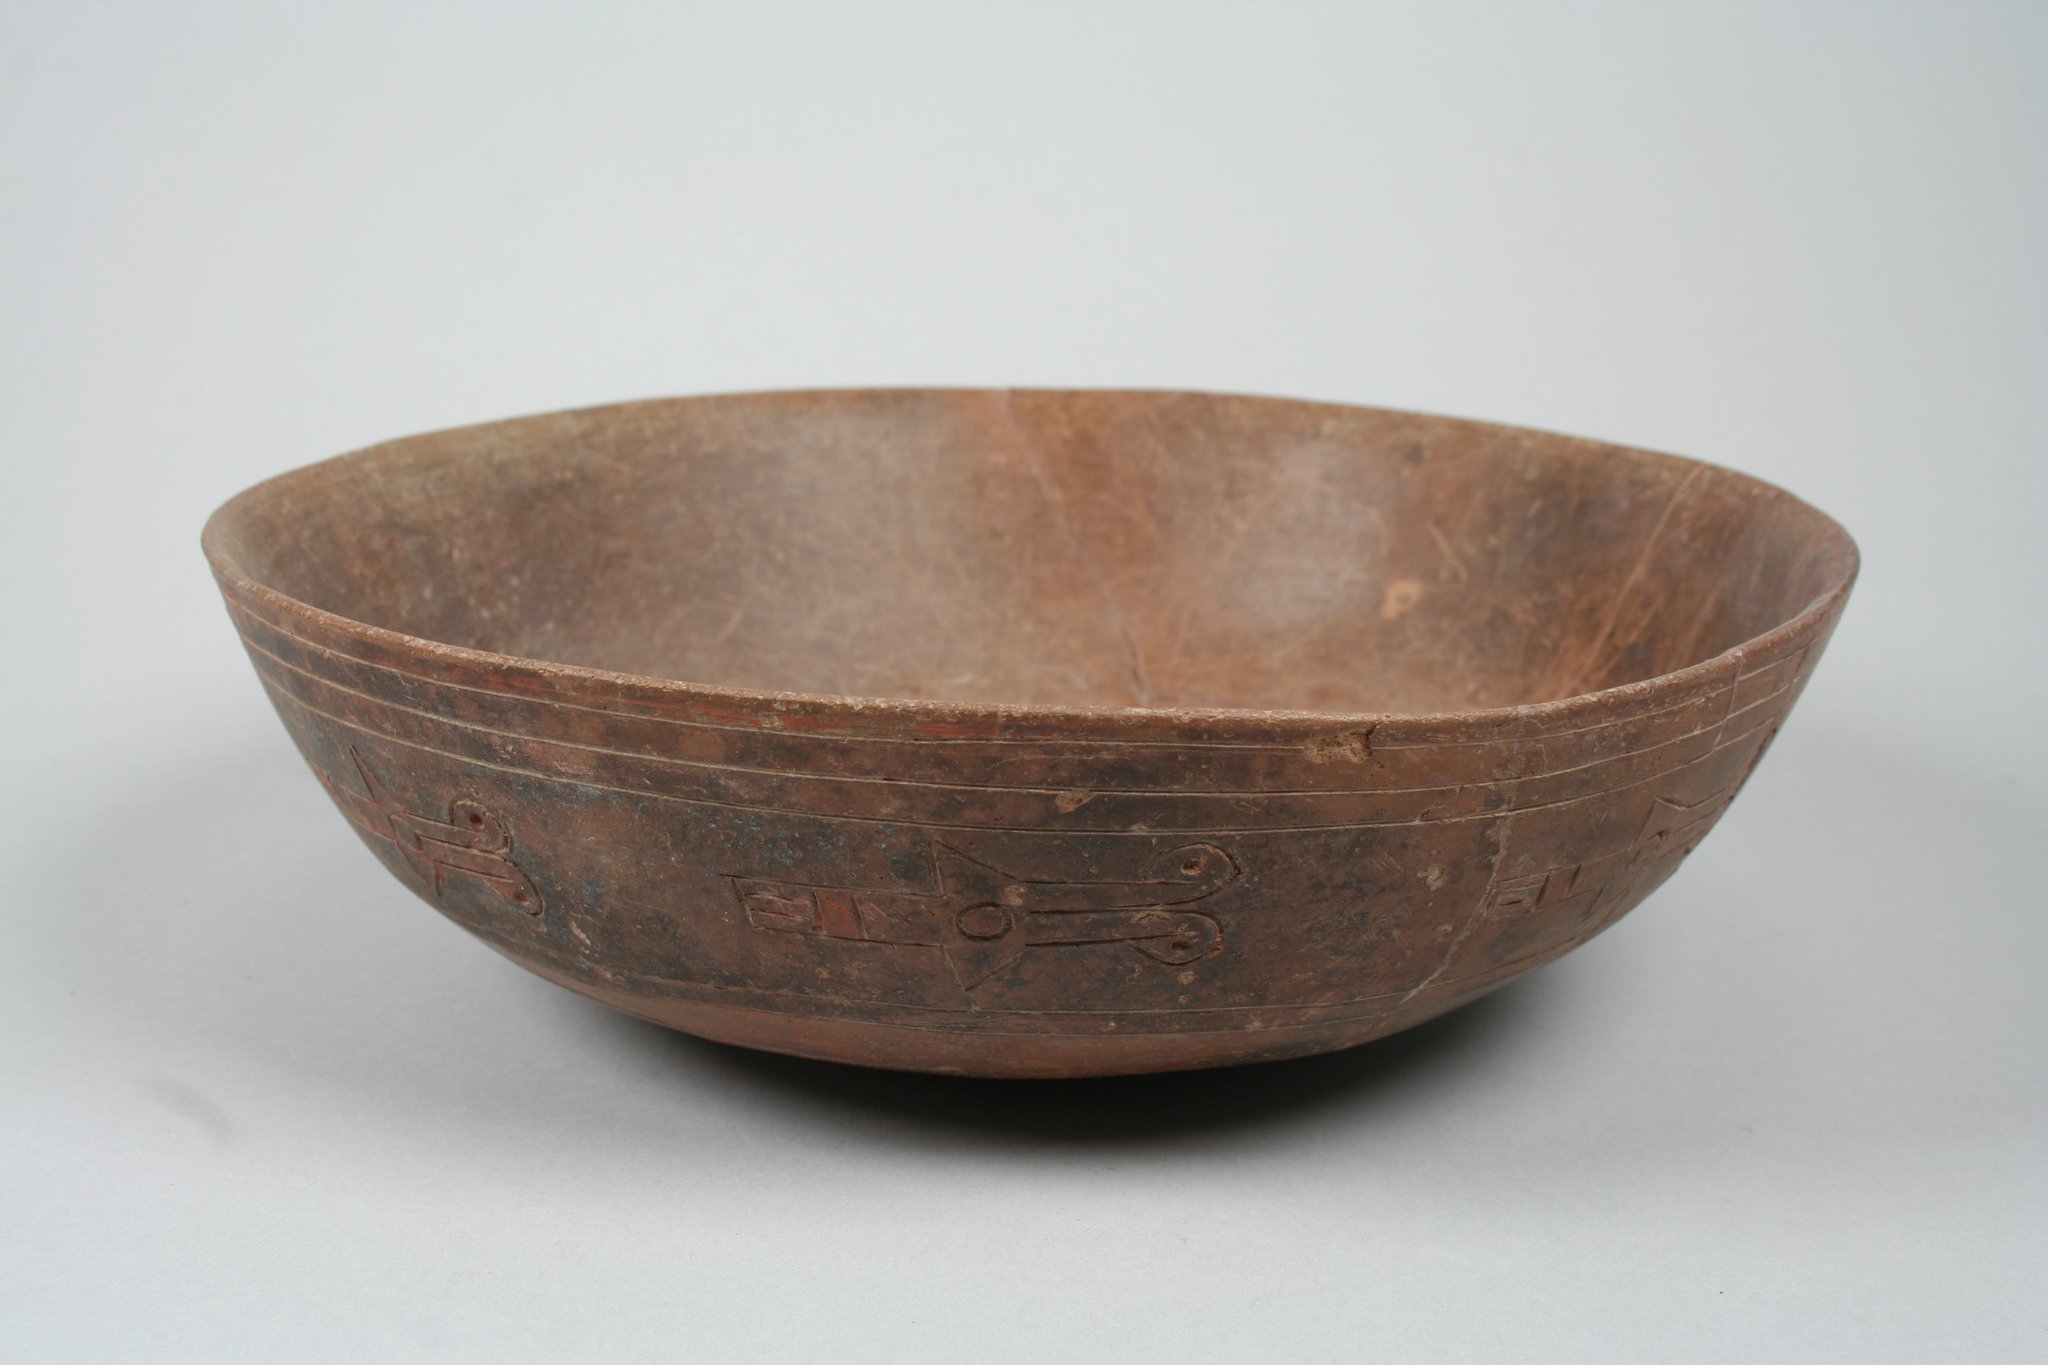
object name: bowl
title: Incised bowl with birds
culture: paracas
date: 300-101 BCE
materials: ceramic, pigment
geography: peru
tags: birds